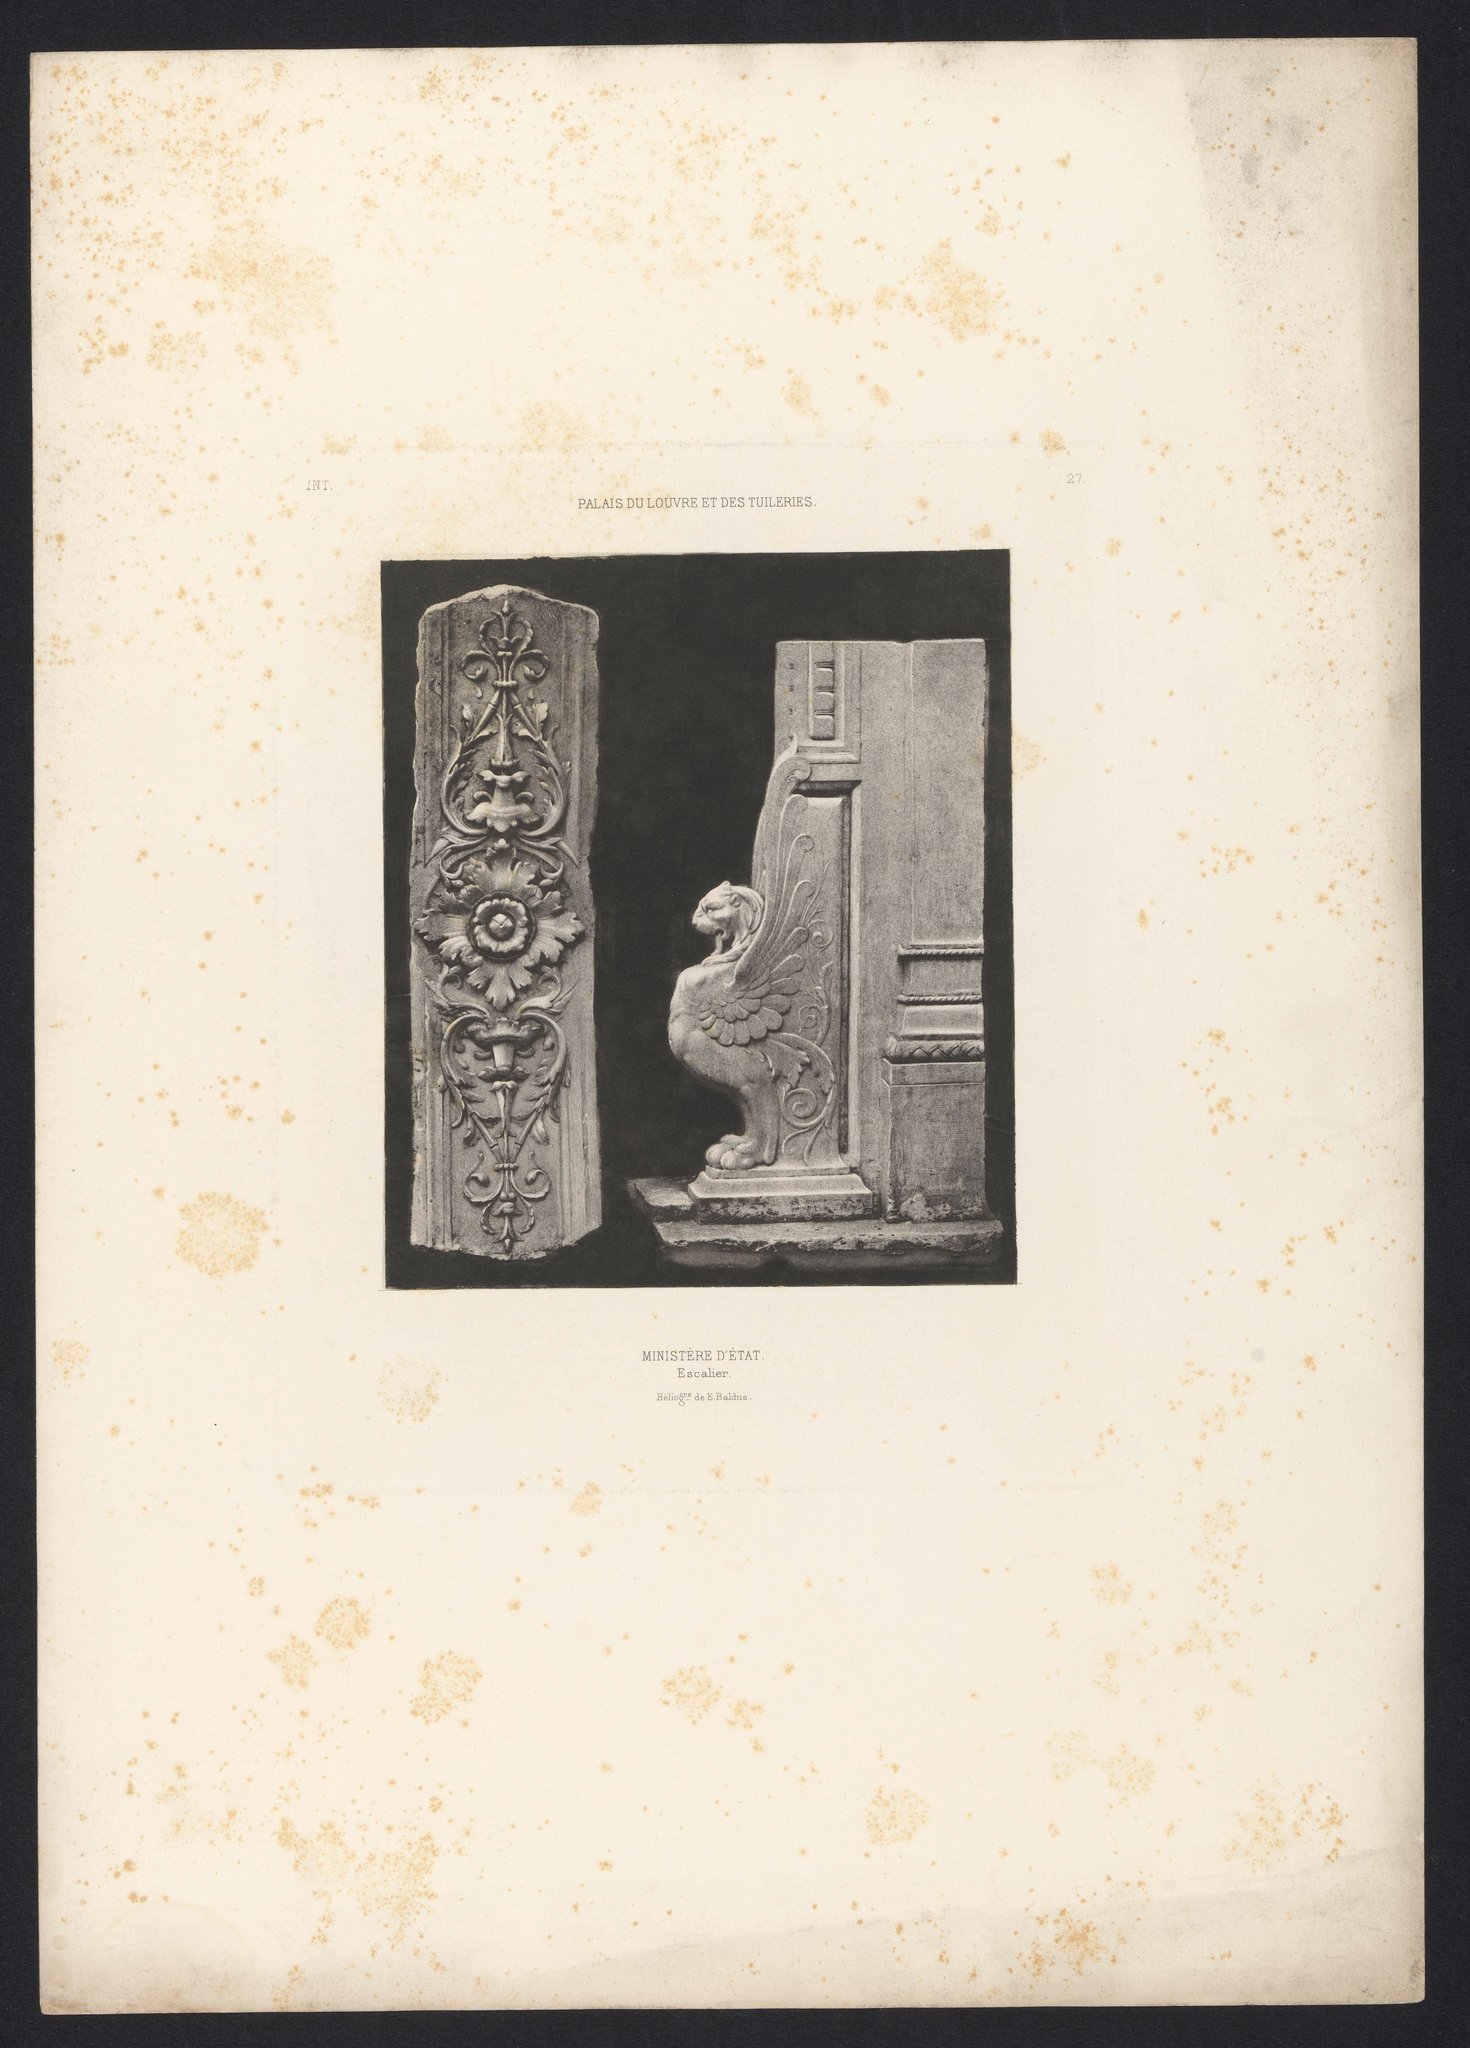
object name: photomechanical print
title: Palais du Louvre et des Tuileries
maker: édouard denis baldus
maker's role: fotograaf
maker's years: 1813-1889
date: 1865-1870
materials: paper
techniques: photoaquatint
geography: france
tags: ornament derived from animal forms, flowers ~ ornament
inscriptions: number: ‘Int. 27’